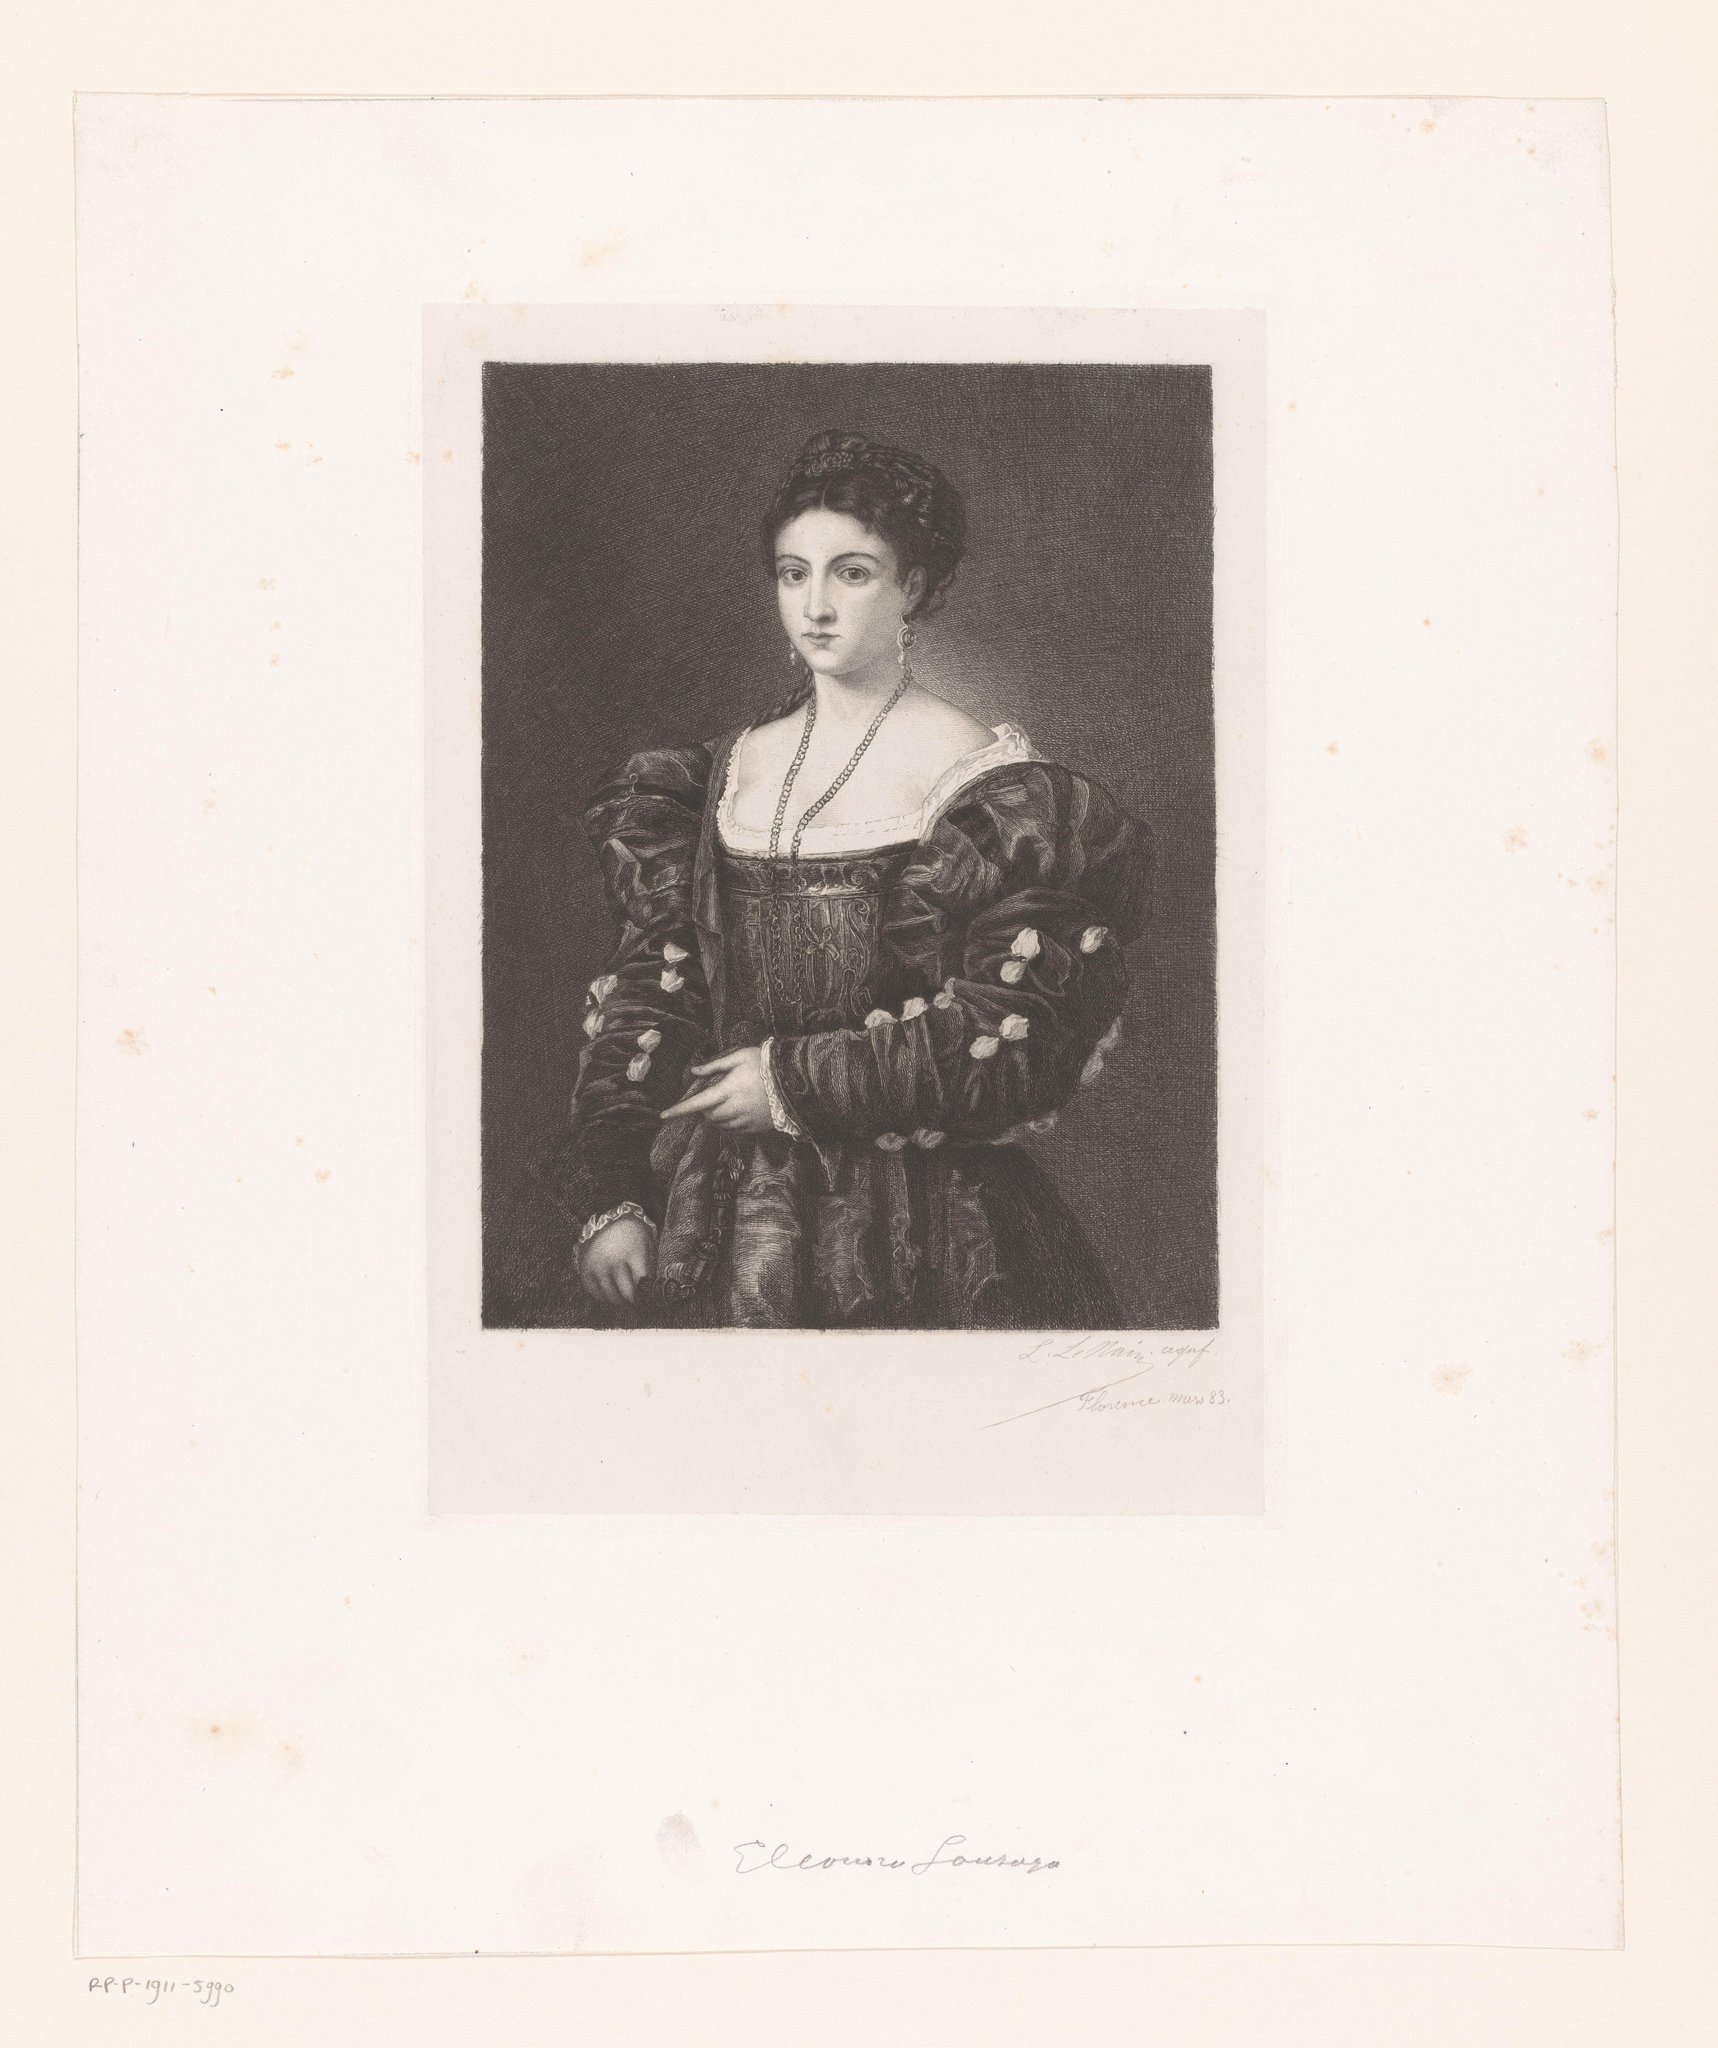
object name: print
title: La Bella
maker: louis le nain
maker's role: print maker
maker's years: 1851-1939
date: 1883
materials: paper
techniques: drypoint, etching, intaglio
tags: adolescent, young woman, maiden, historical persons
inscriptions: inscription: ‘L. Le Nain aquf. Florence mars 83’, collector's mark: Lugt 2228